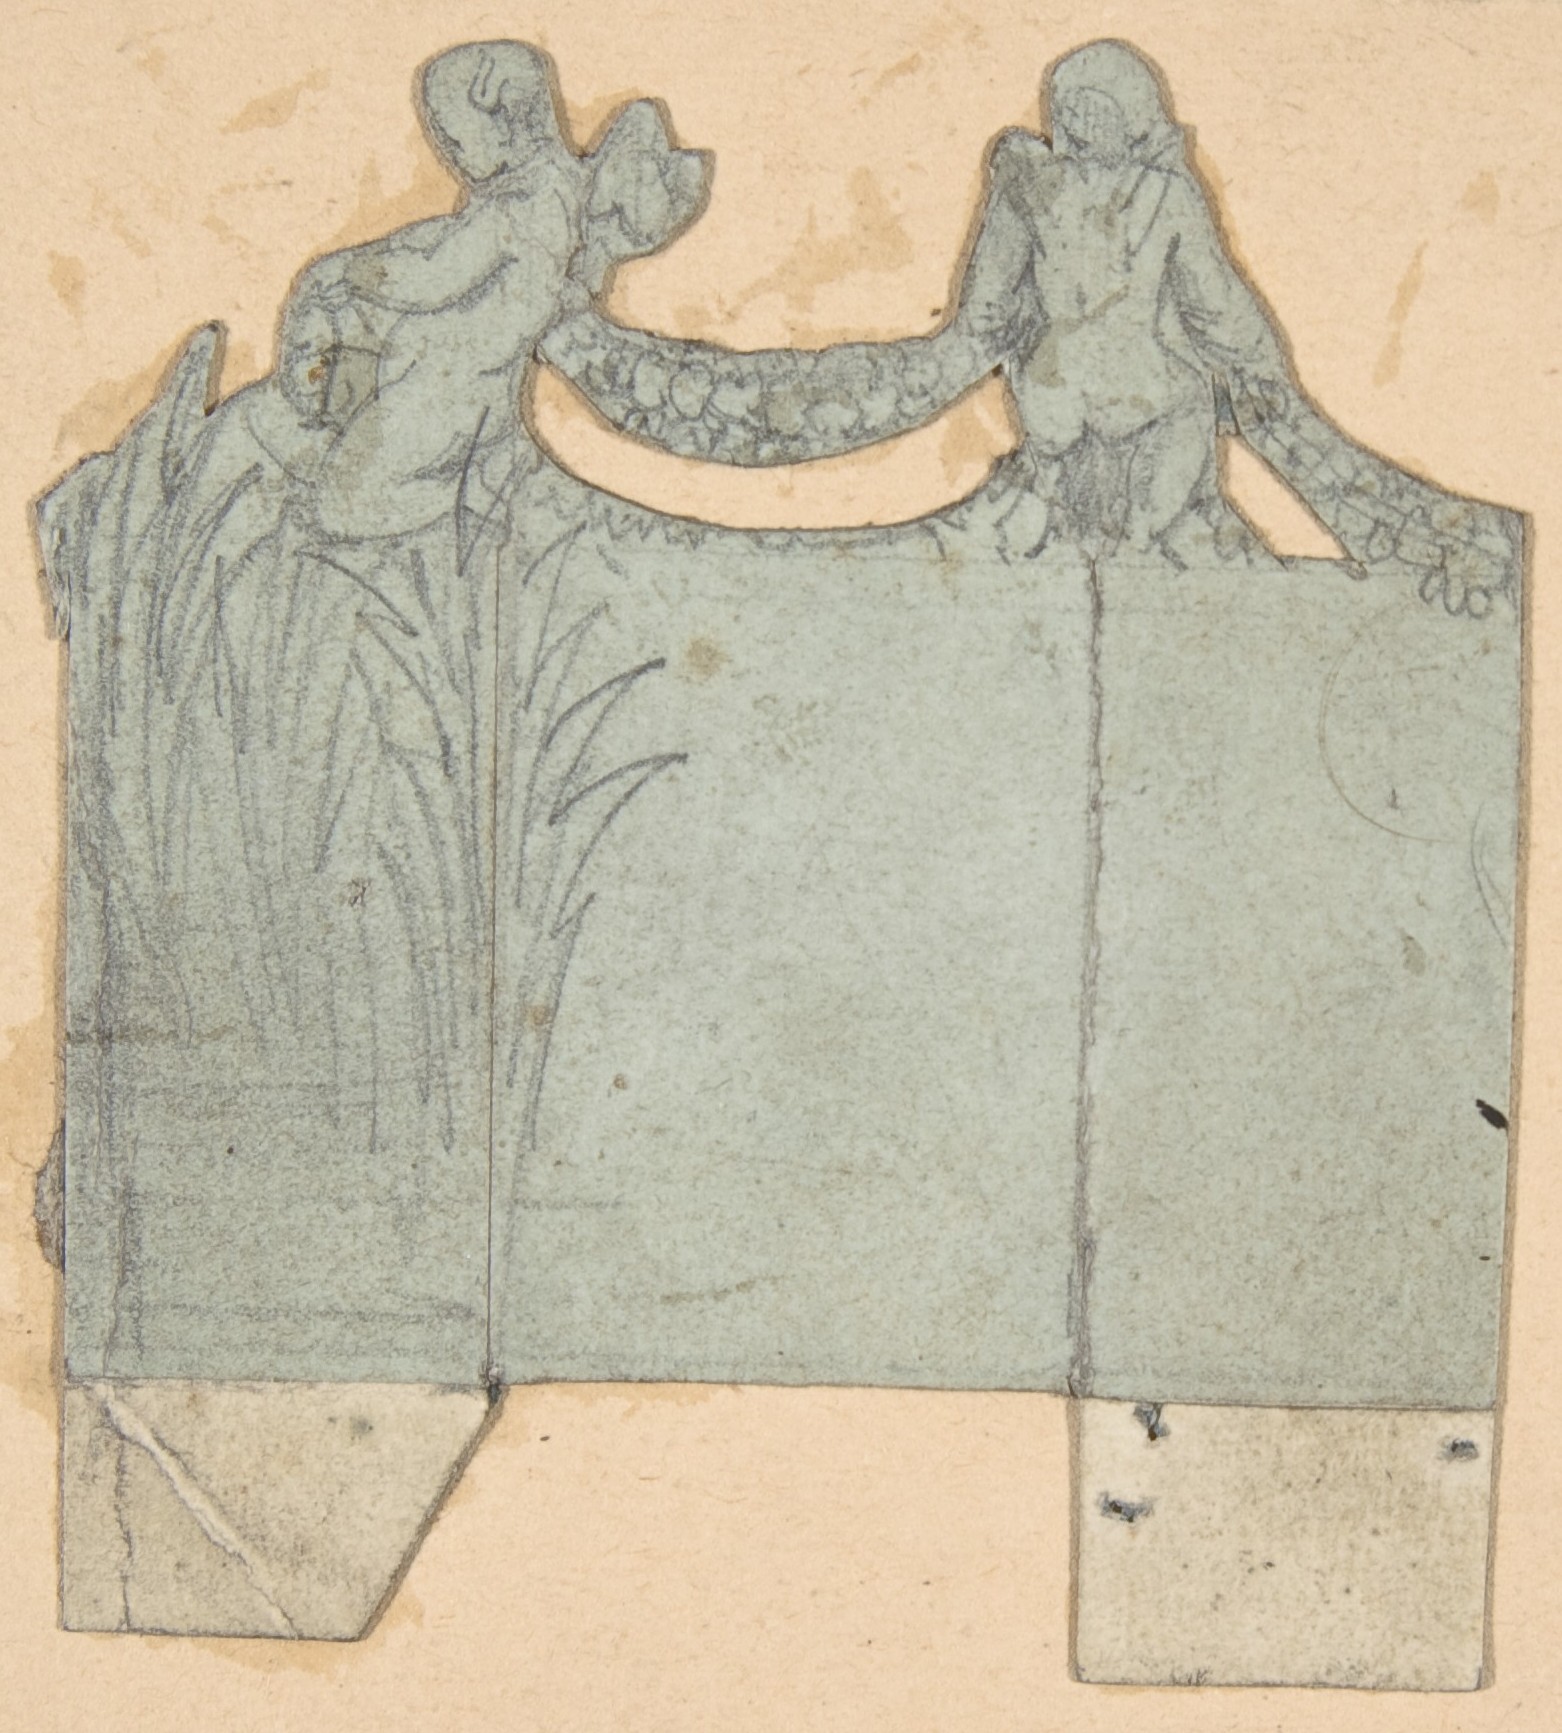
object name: drawing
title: Design for a Stage Set at the Opéra, Paris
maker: eugène cicéri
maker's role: artist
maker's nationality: french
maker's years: 1813-1890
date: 1828-1890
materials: gouache, graphite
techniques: brush, wash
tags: stage design